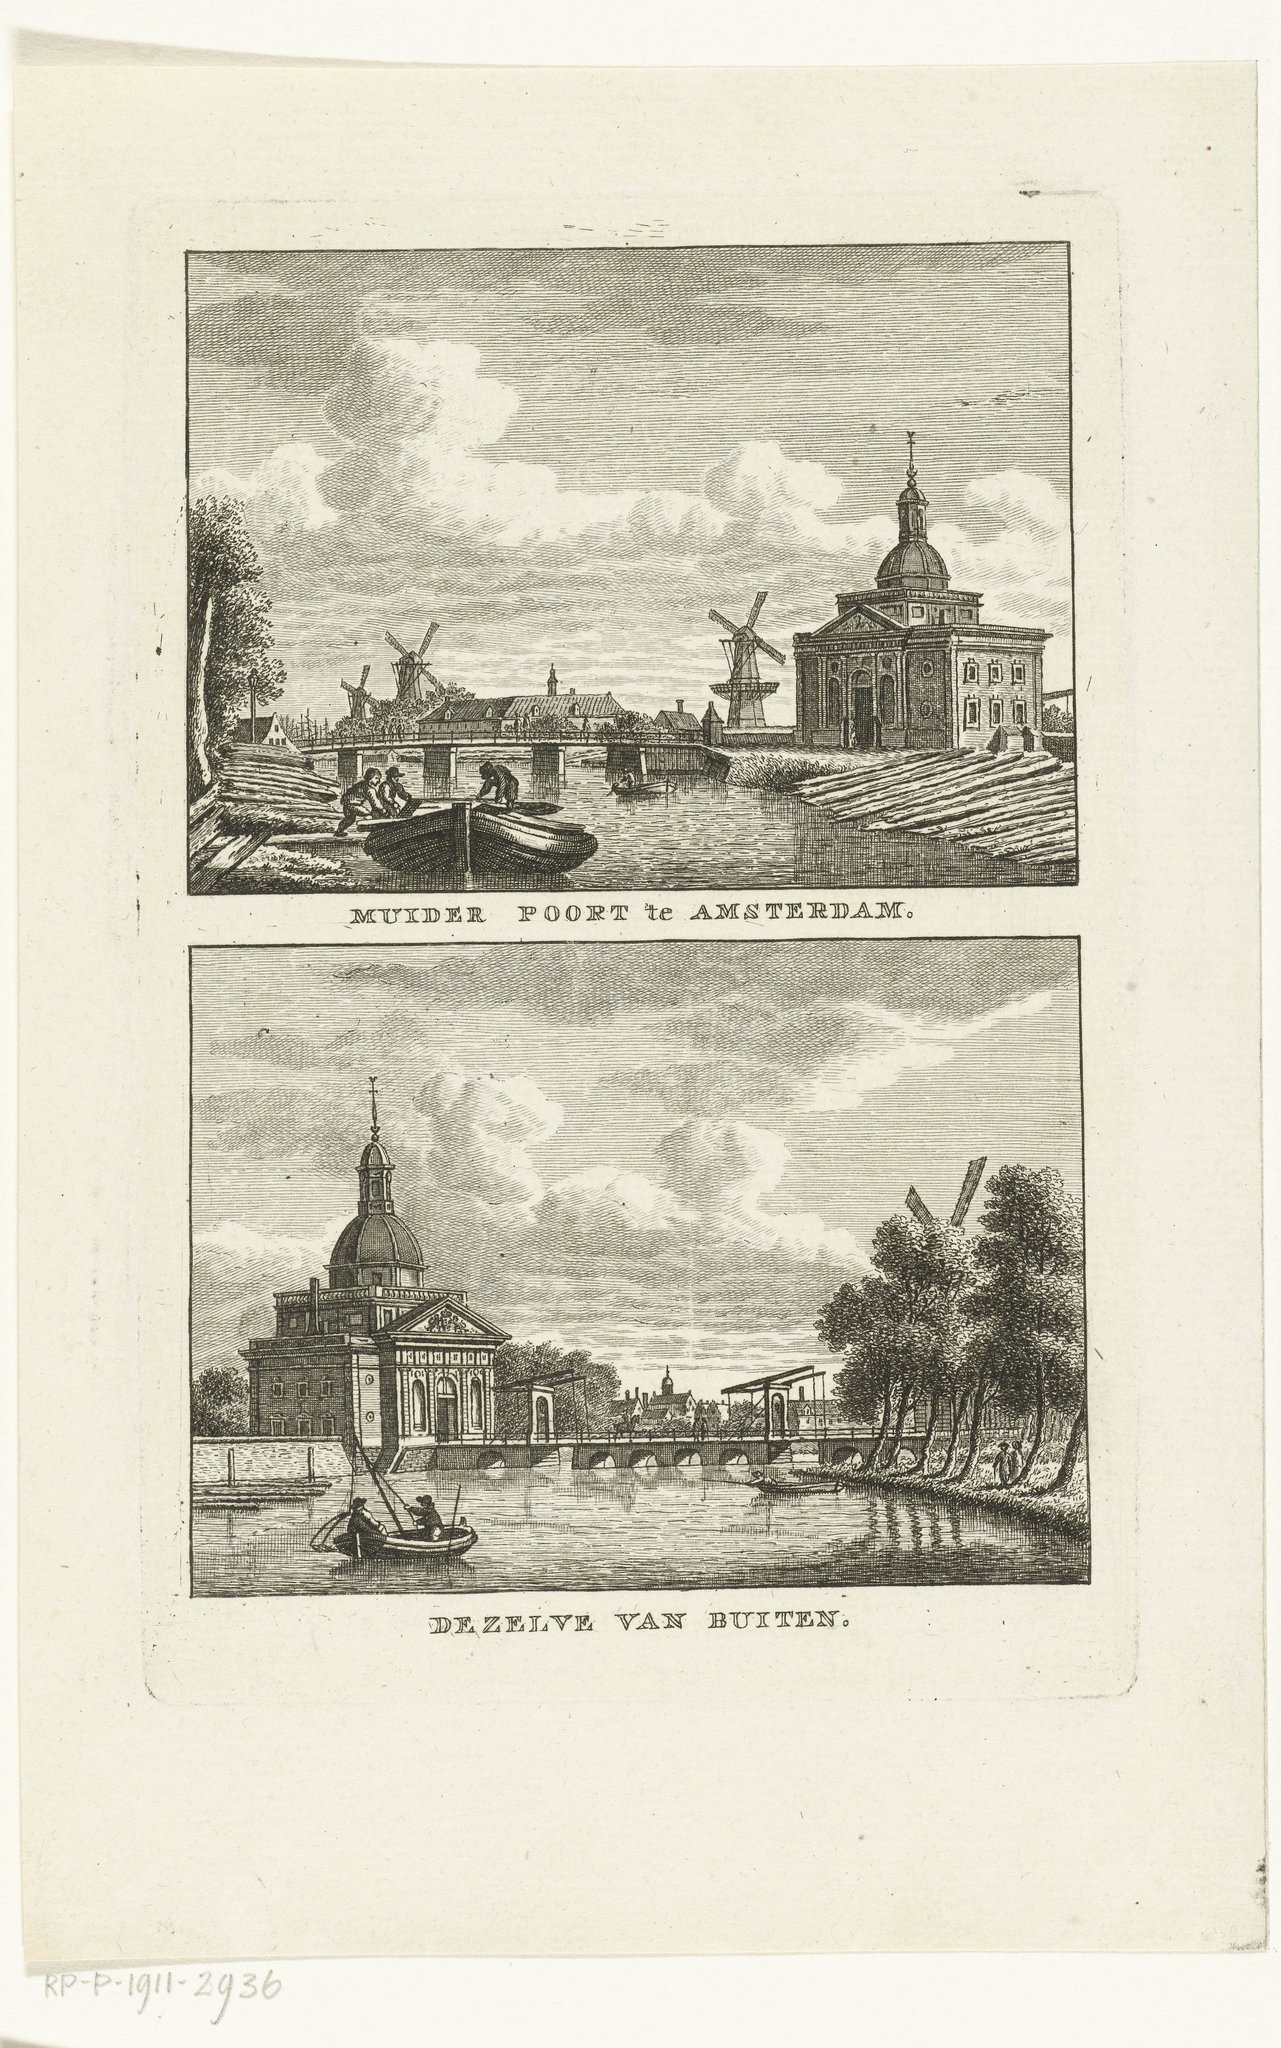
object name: print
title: Muider Poort te Amsterdam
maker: carel frederik bendorp (i)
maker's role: print maker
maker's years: 1736-1814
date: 1786-1792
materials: paper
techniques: etching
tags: city-gate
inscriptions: collector's mark: Lugt 2228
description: Prent uit: Vaderlandsche gezichten, of afbeeldingen van den tegenwoordigen staat der Vereenigde Nederlanden (…). Amsterdam: Hendrik Gartman, Willem Vermandel en Jan Willem Smit, 1786-1792. Uitgegeven in afleveringen met ieder een eigen bifolium en inhoudsopgave. Alle prenten in deze publicatie zijn gegraveerd door Carel Frederik Bendorp (I) en, in de meeste gevallen, gebaseerd op tekeningen van Jan Bulthuis.